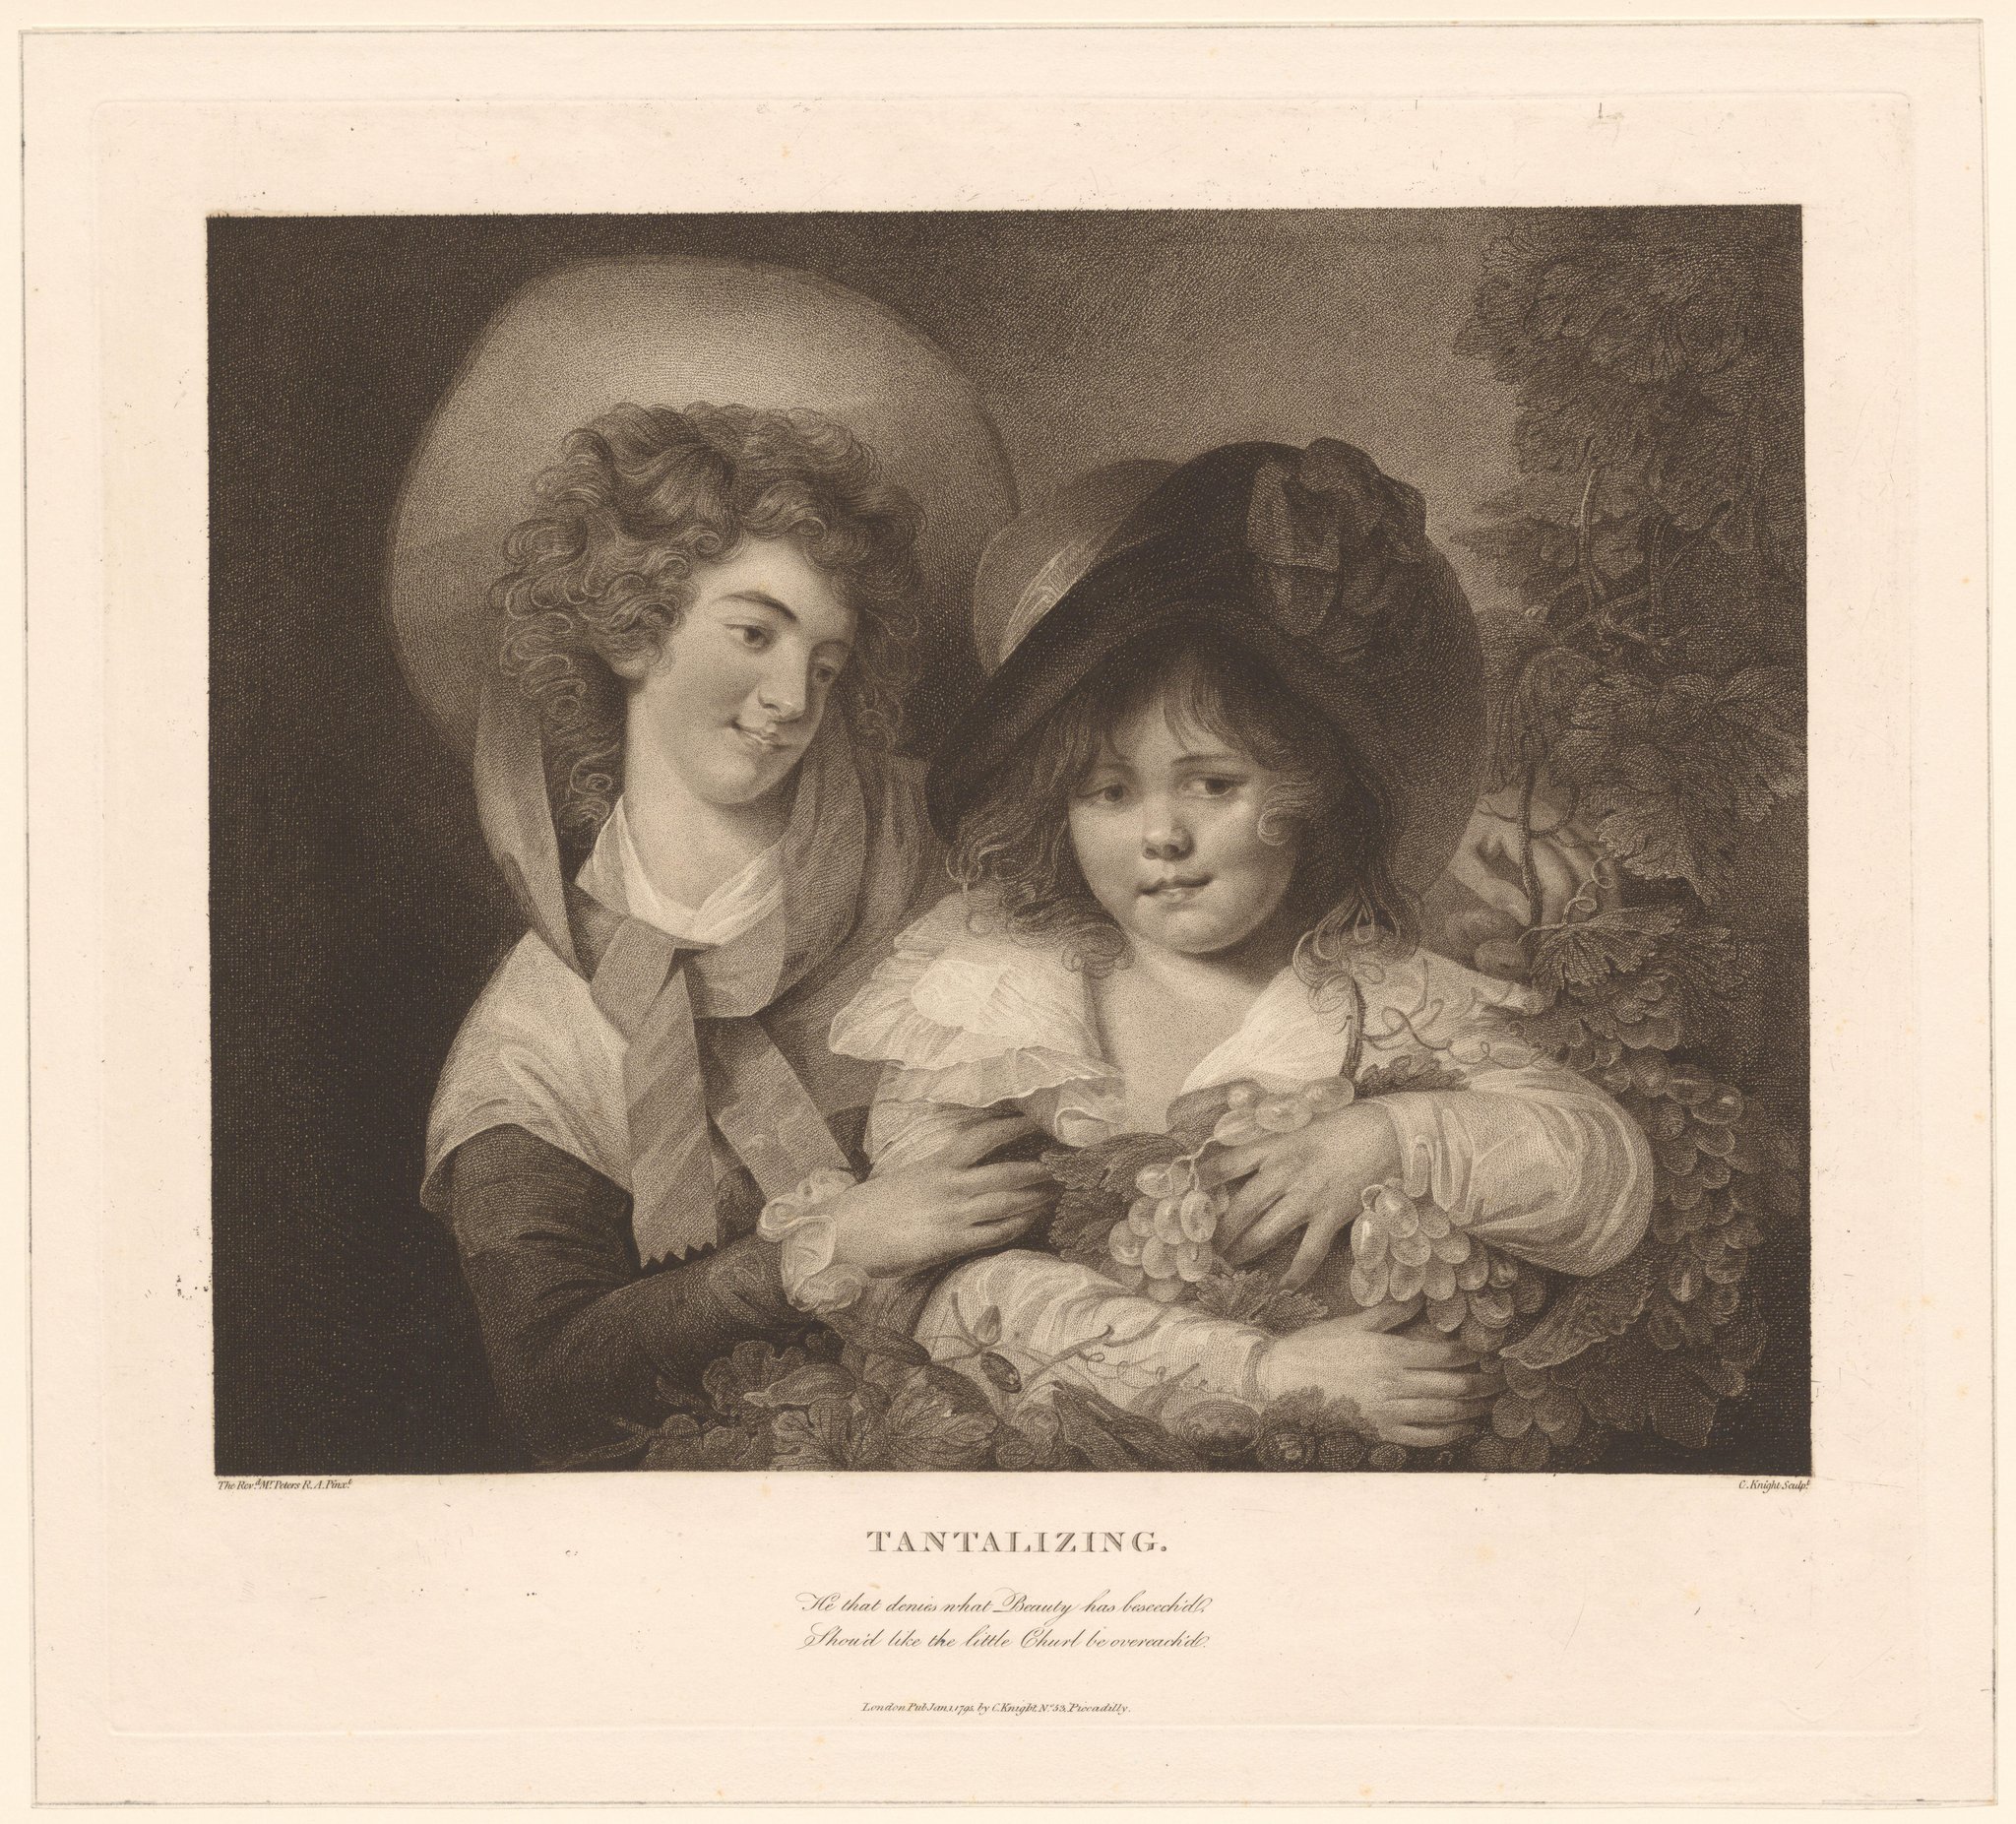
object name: print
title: Twee kinderen met druiven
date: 1795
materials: paper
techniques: etching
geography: london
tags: children's games and plays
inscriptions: collector's mark: Lugt 2233